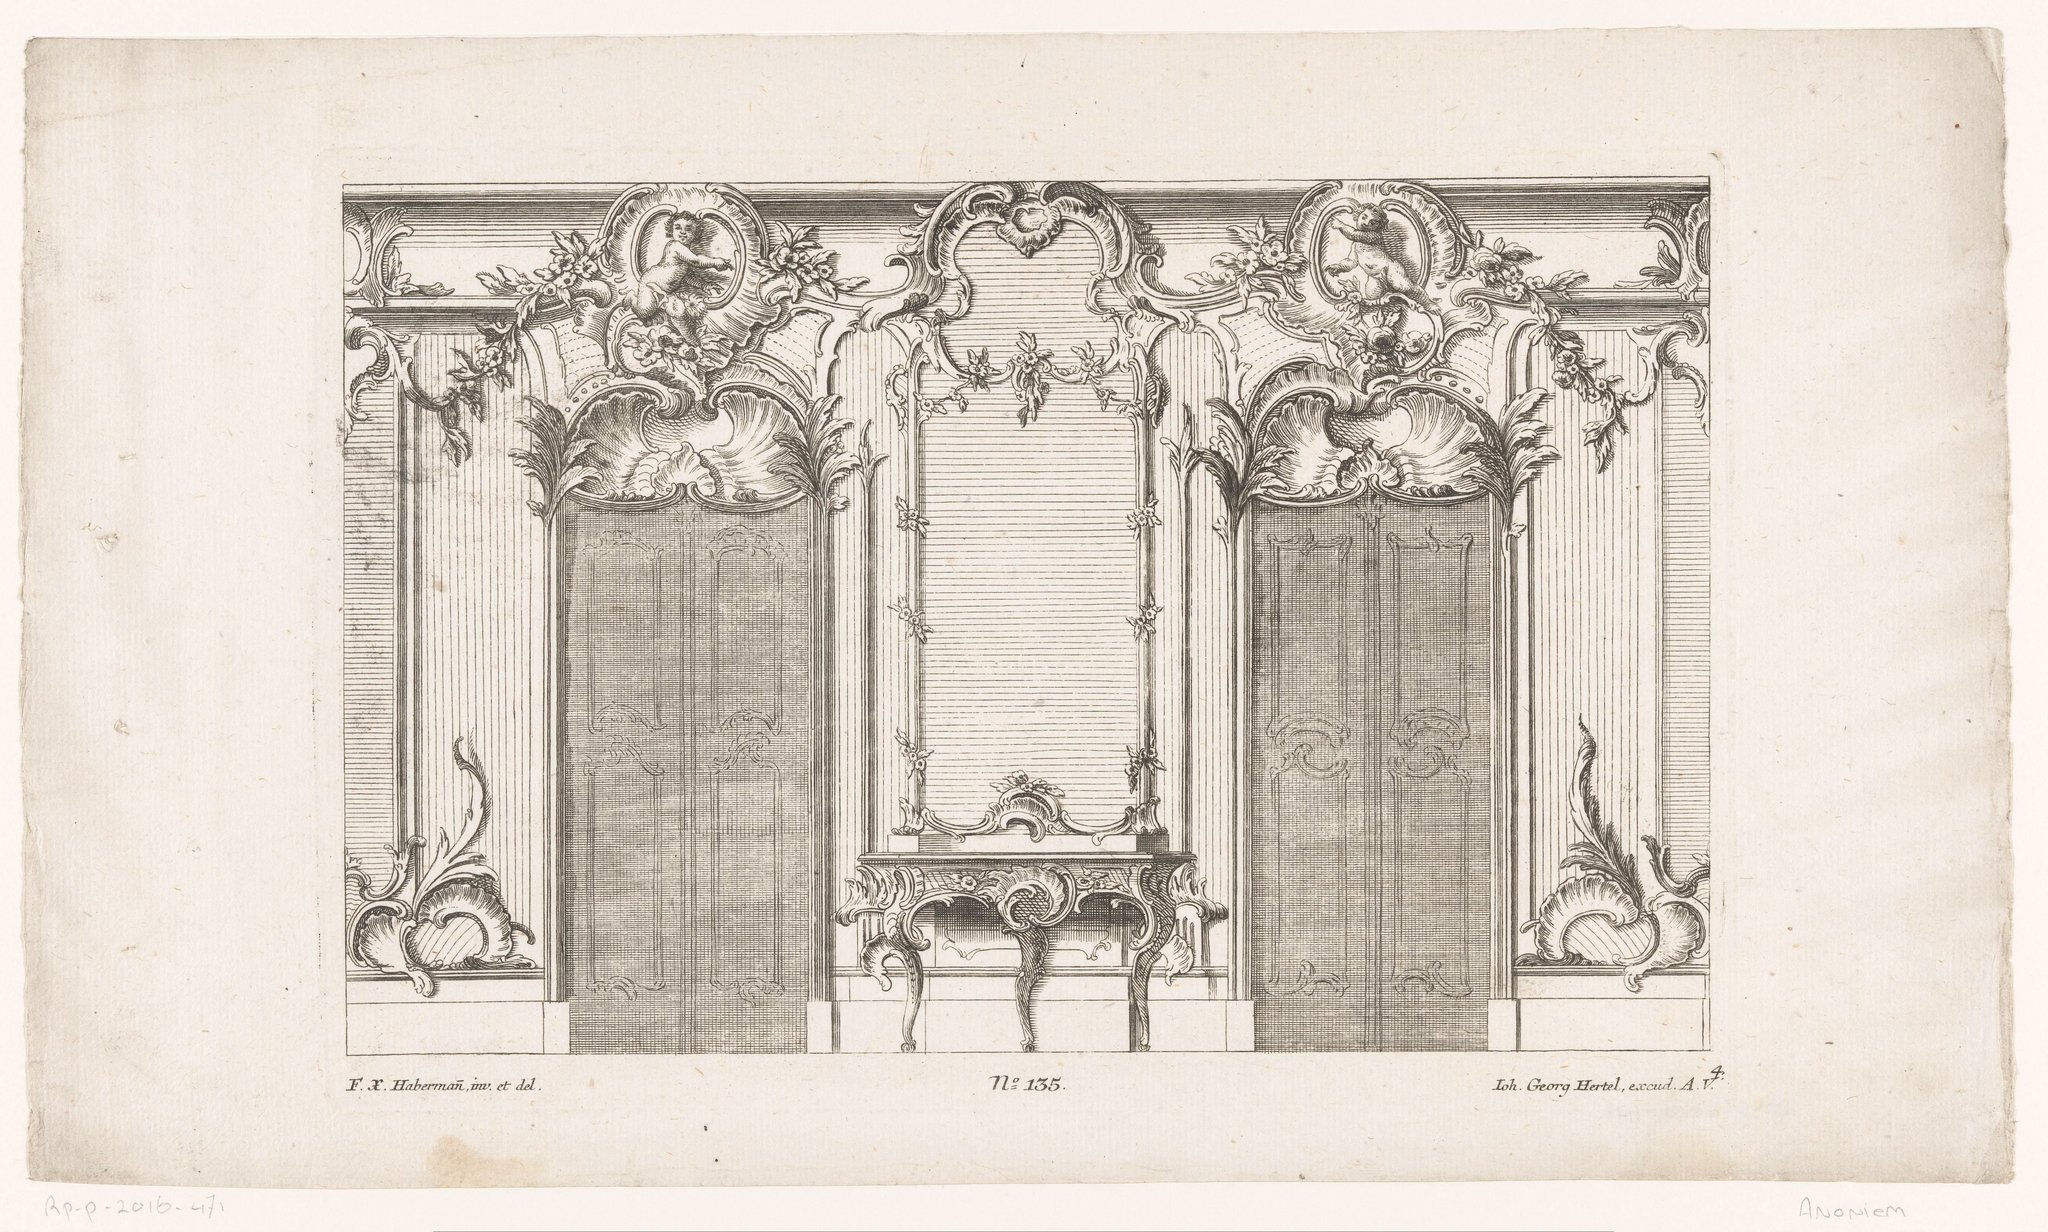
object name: ornament print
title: Wandindeling met deuren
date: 1748-1753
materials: paper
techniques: engraving, etching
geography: augsburg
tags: rocaille ornament, door, wall-covering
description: Wandindeling met twee deuren met rocaille omlijsting en bekroond met rocaille cartouche met putti. In het midden een met rocailles versierde tafel. Uitgeversnummer 135.